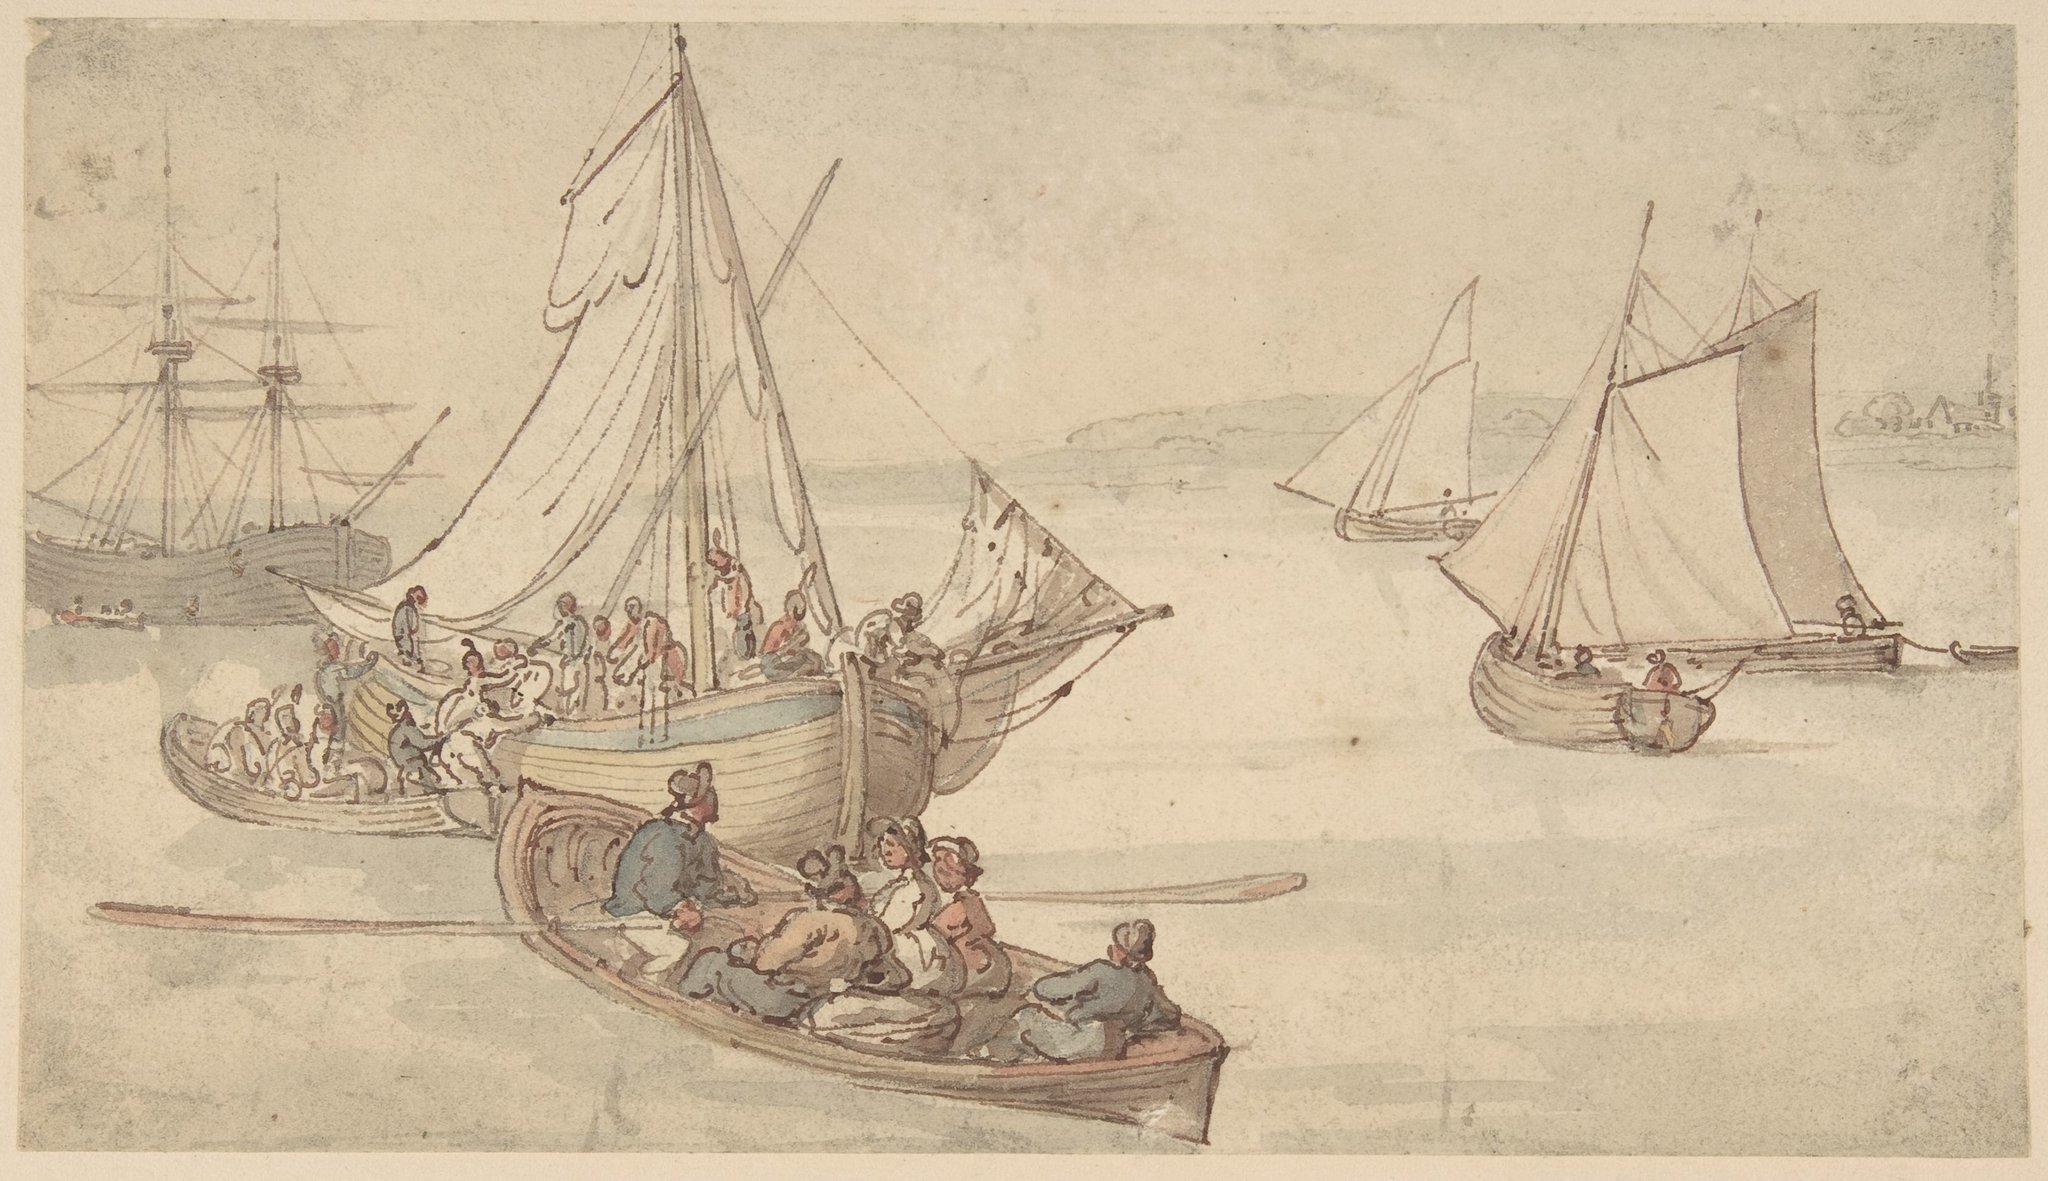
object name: drawing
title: Ships and Sailors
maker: thomas rowlandson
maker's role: artist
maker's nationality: british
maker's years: 1757-1827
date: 1767-1833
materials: watercolor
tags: men,women,sailors,boats,ships